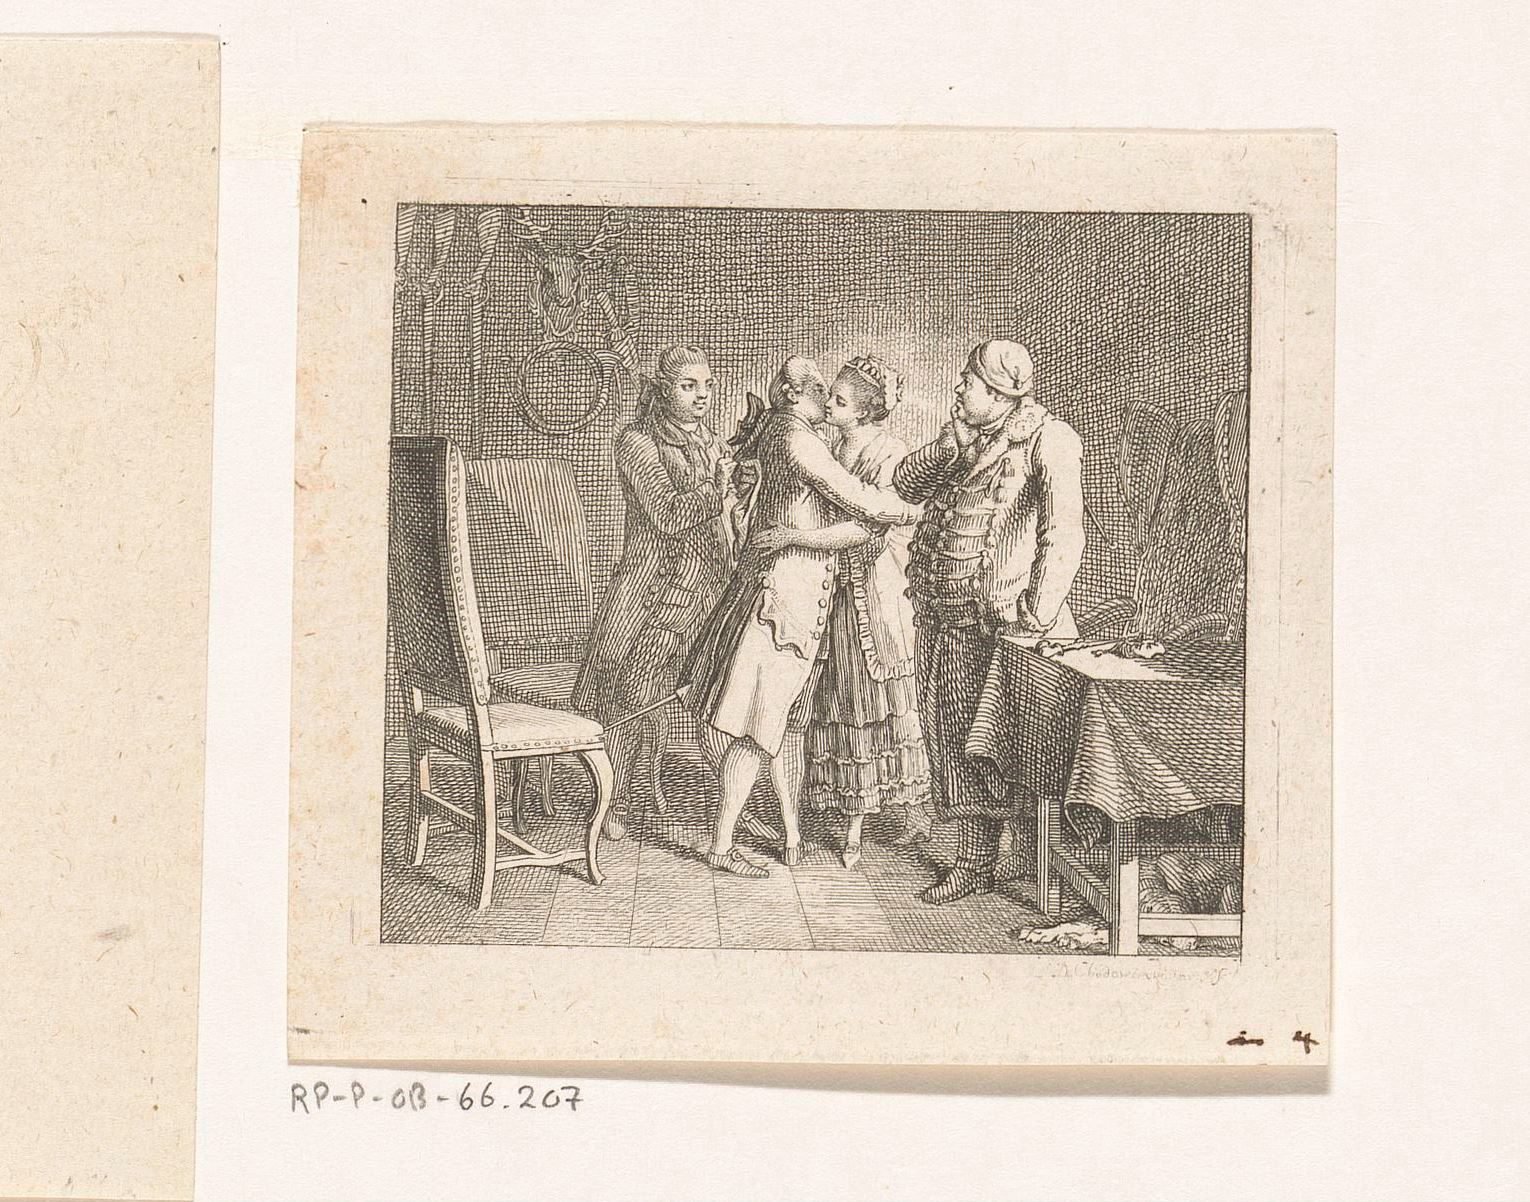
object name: print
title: Werther omhelst Lotte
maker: daniel nikolaus chodowiecki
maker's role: draughtsman, print maker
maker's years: 1726-1801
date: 1775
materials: paper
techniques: etching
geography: berlin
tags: berlin, publisher, friedrich nicolai, draughtsman, johann wolfgang von goethe, (scenes from) specific works of literature: goethe, werther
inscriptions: collector's mark: Lugt 240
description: De tweede staat van deze prent is ook gebruikt in: [Nicolai, Friedrich]. Freuden des jungen Werthers. Leiden und Freuden Werthers des Mannes. Voran und zuletzt ein Gespräch. Berlijn: Friedrich Nicolai, 1775. Het betreft hier een parodie op 'Die Leiden des jungen Werthers' door Johann Wolfgang von Goethe.